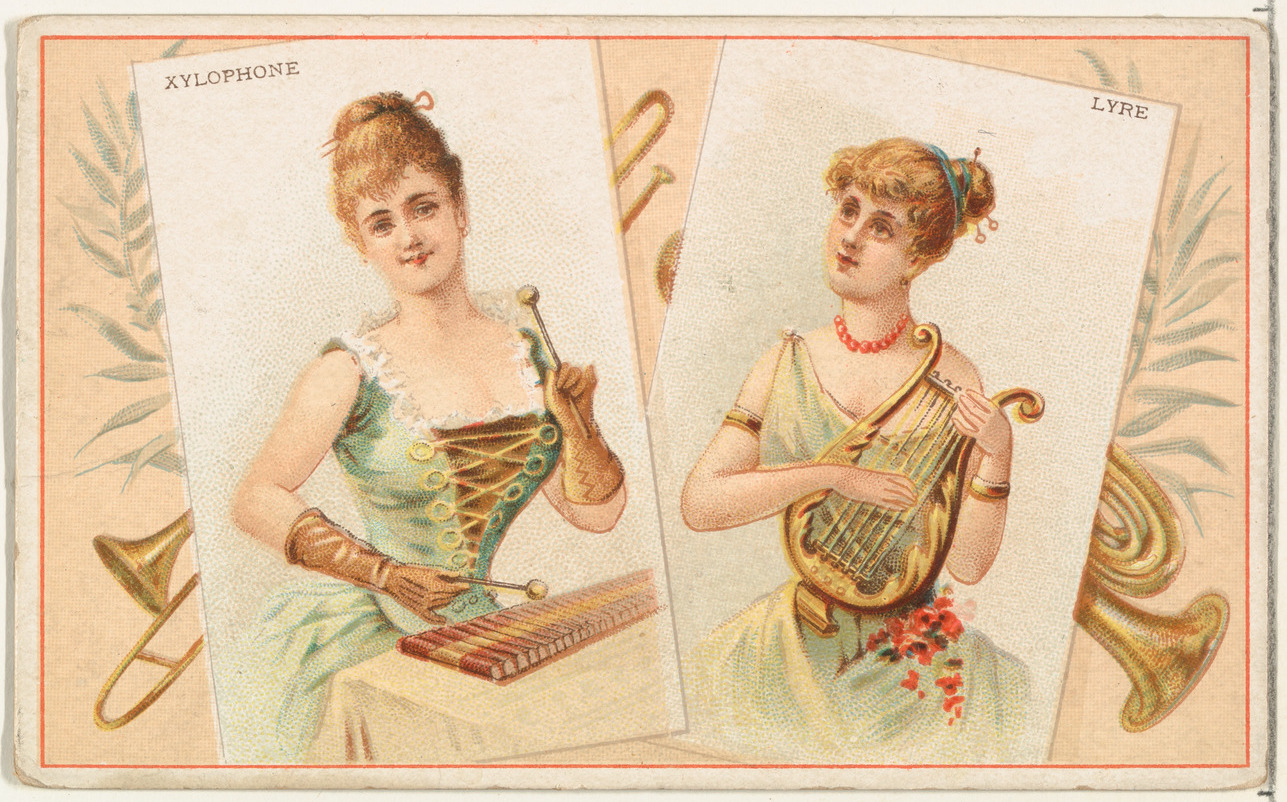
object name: print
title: Xylophone and Lyre, from the Musical Instruments series (N121) issued by Duke Sons & Co. to promote Honest Long Cut Tobacco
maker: w. duke, sons & co.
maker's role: publisher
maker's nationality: american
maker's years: 1870-1920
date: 1888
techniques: color lithograph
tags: musical instruments,women